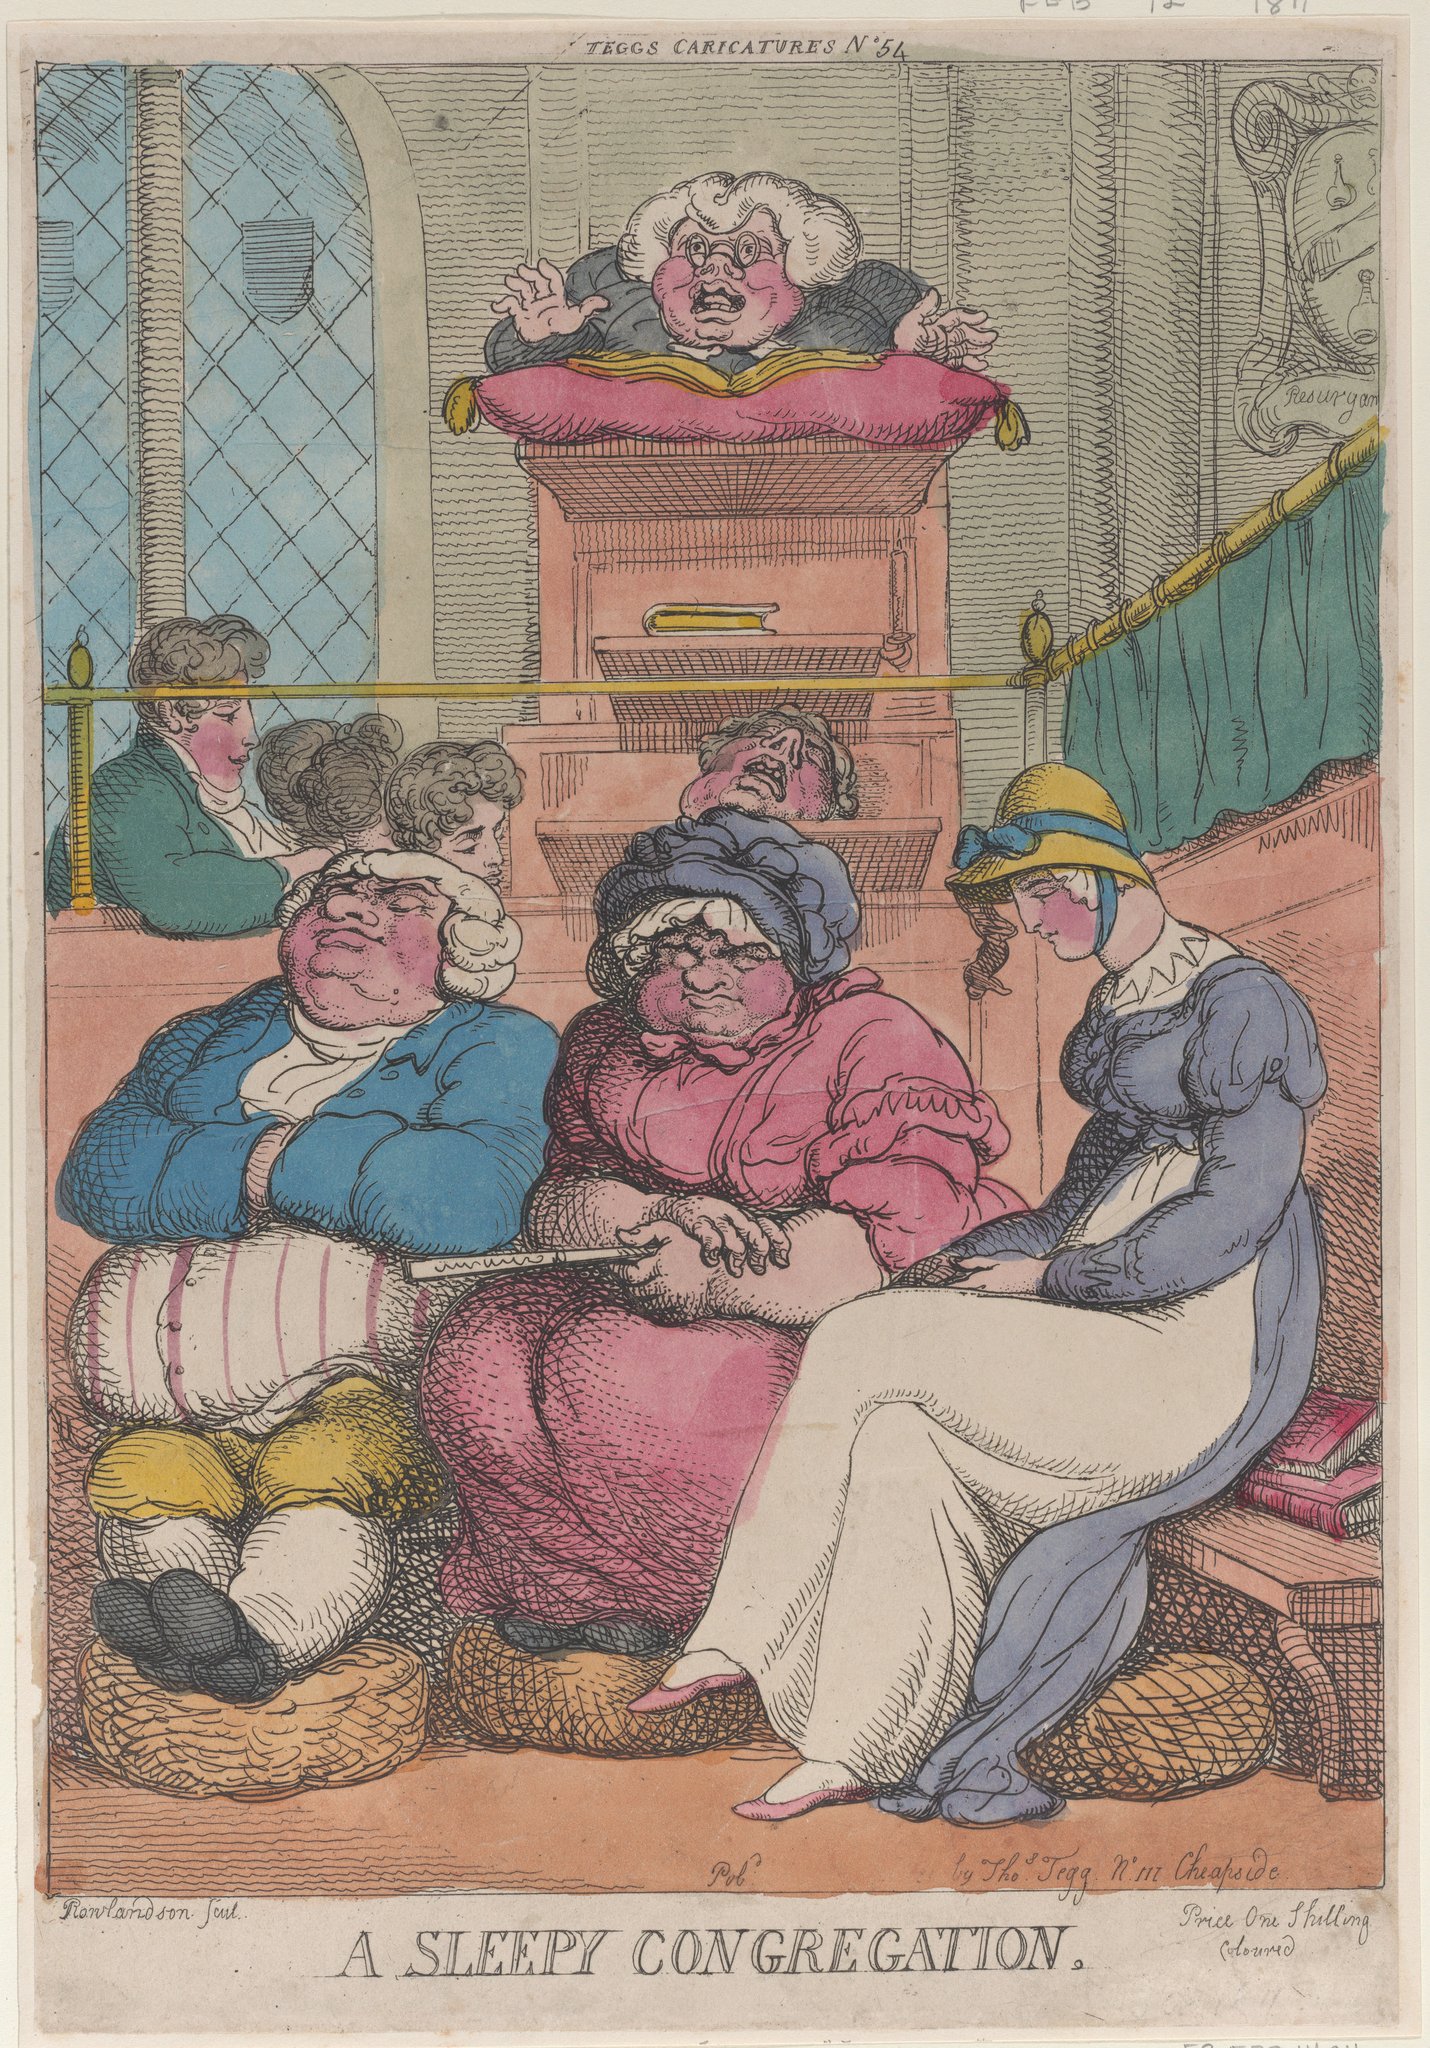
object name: print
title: A Sleepy Congregation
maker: thomas rowlandson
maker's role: artist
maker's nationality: british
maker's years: 1757-1827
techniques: etching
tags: satire,churches,sleeping,men,women